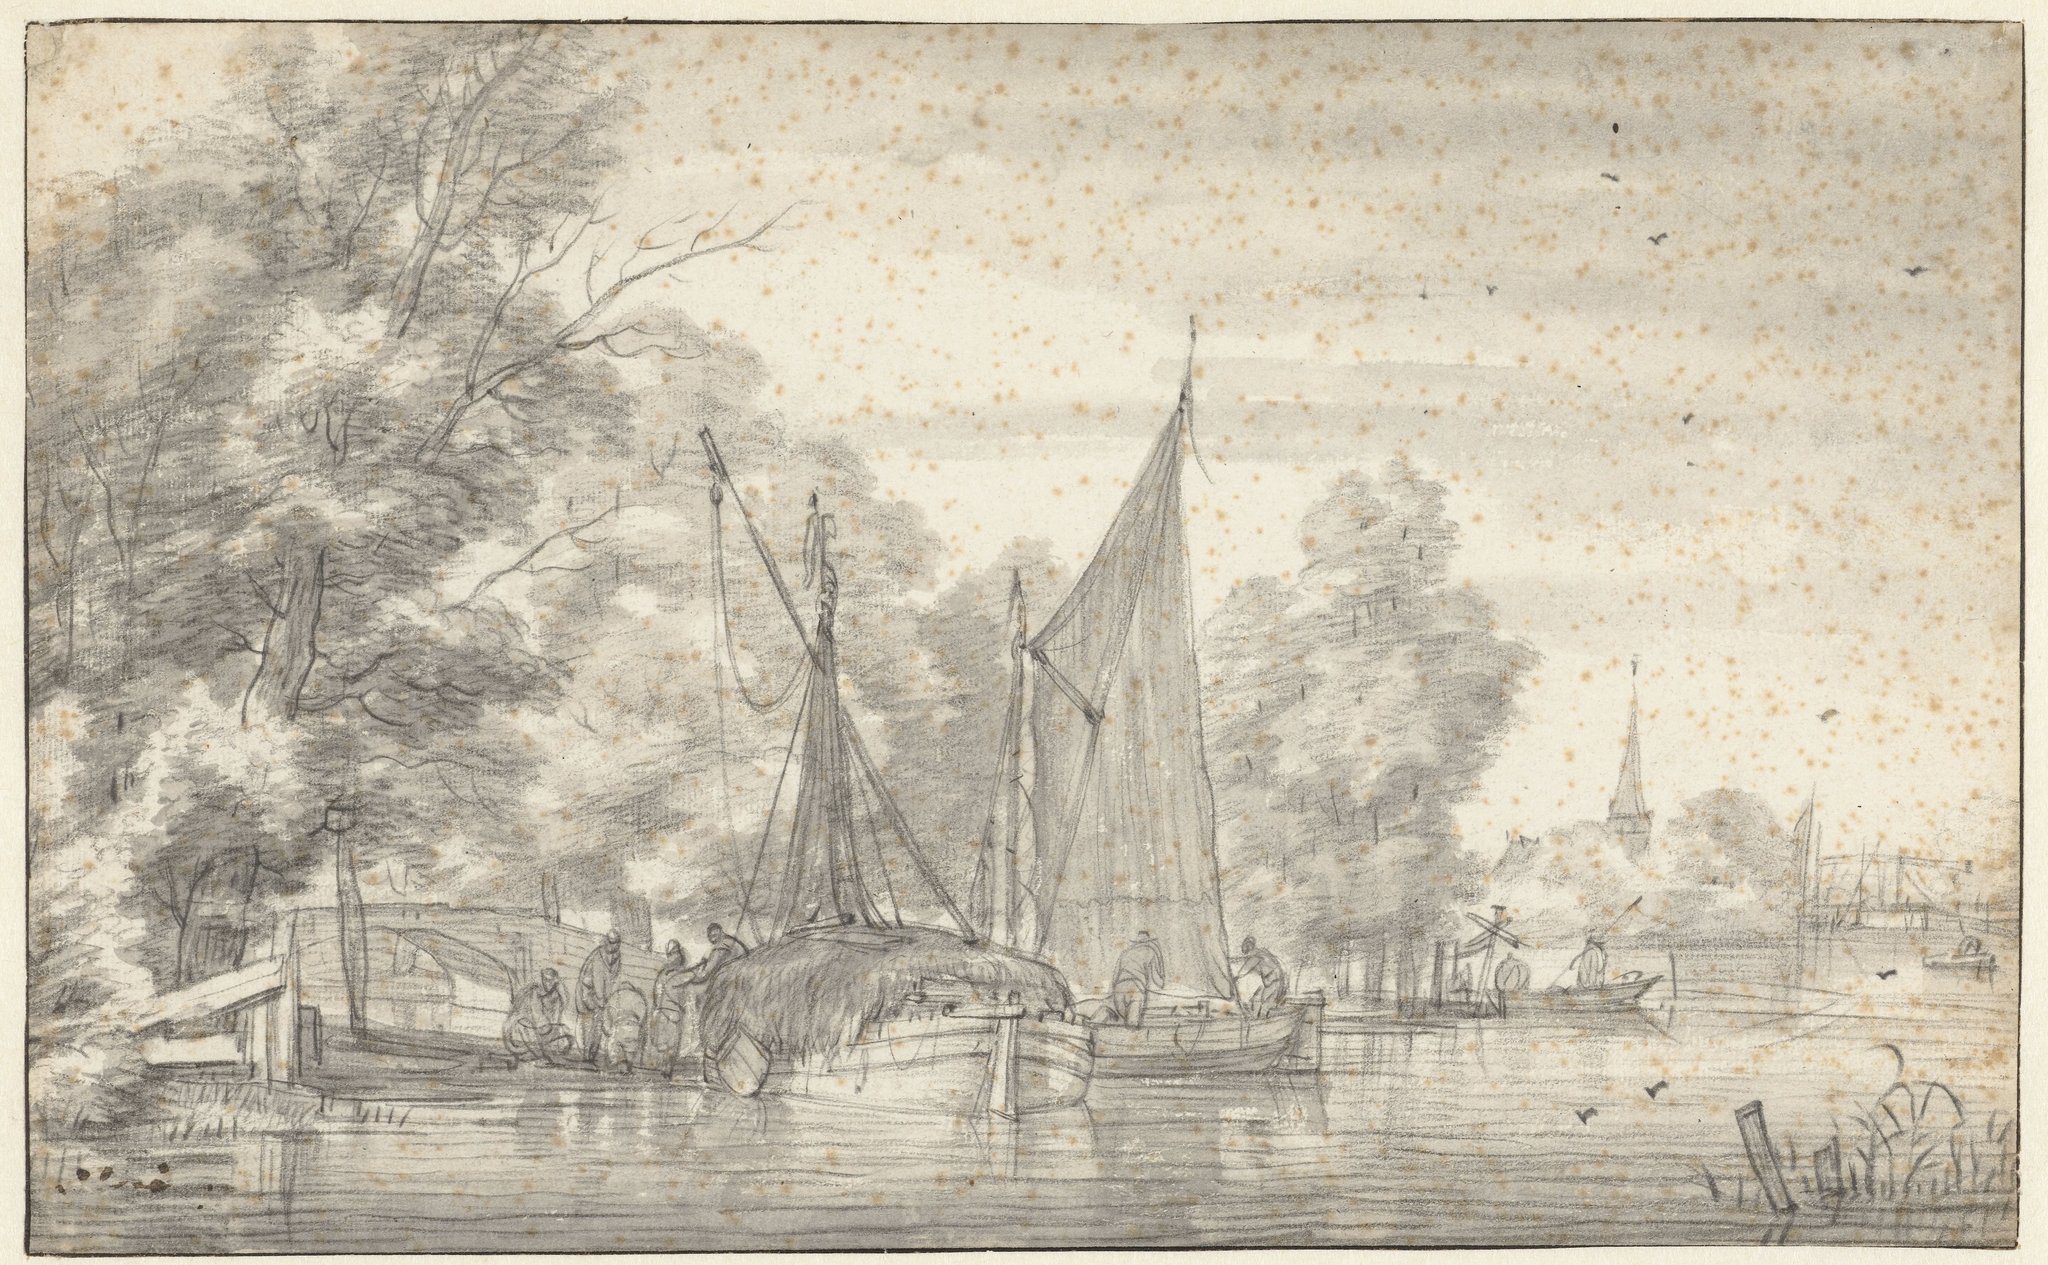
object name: drawing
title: Gezicht op een rivier met mensen bij en op boten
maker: jacob esselens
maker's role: draughtsman, print maker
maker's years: 1626-1687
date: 1636-1687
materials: chalk, paper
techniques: brush